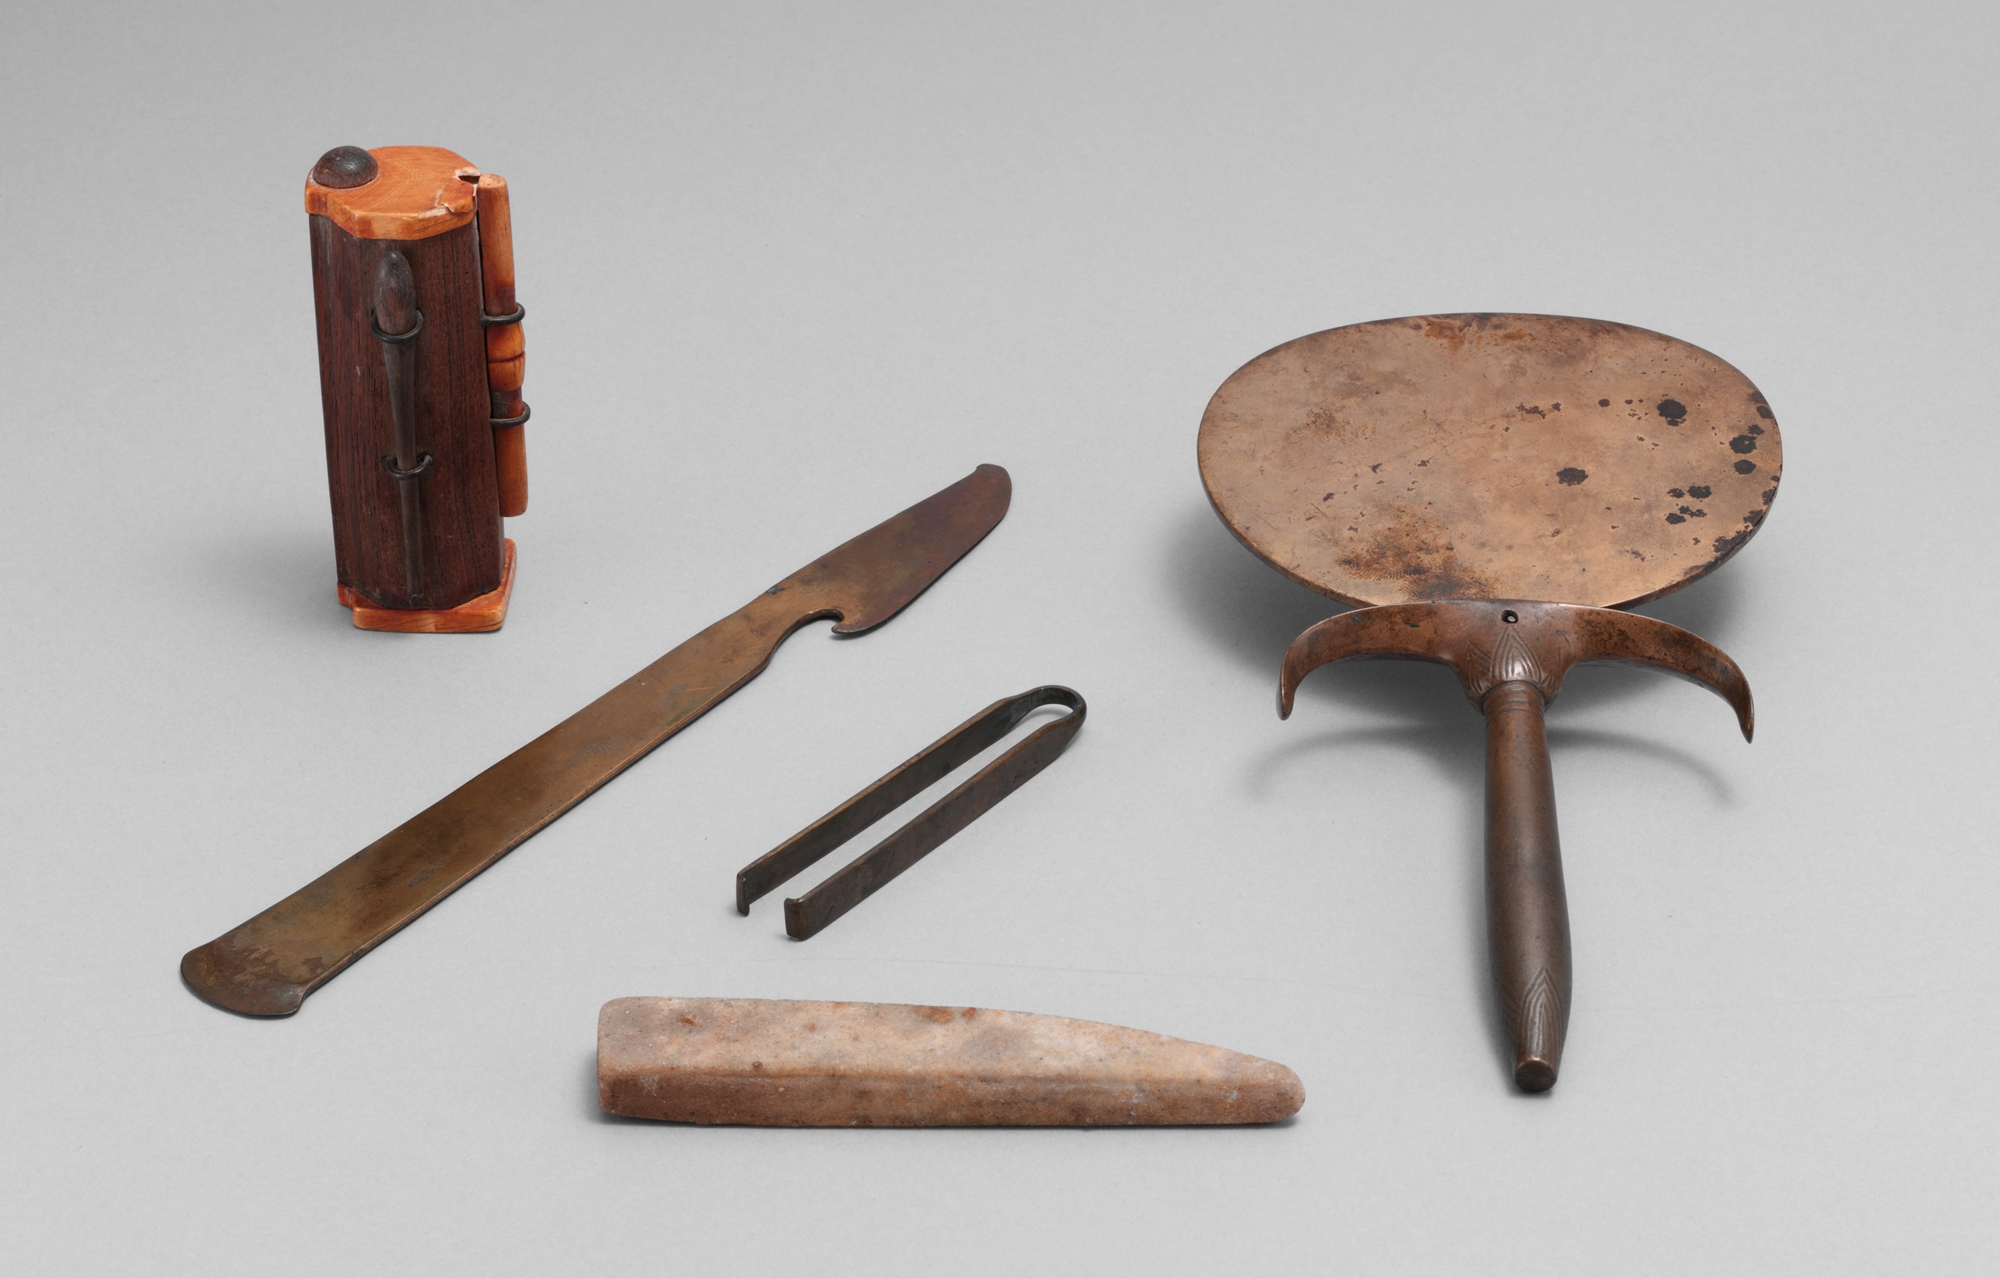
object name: mirror, razor, tweezer, whetstone, kohl tube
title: Cosmetic set of Kohl Tube and Applicator, Razor, Tweezers, Whetstone, and Mirror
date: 1550-1458 BCE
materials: bronze, copper alloy, ivory, stone, wood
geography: egypt